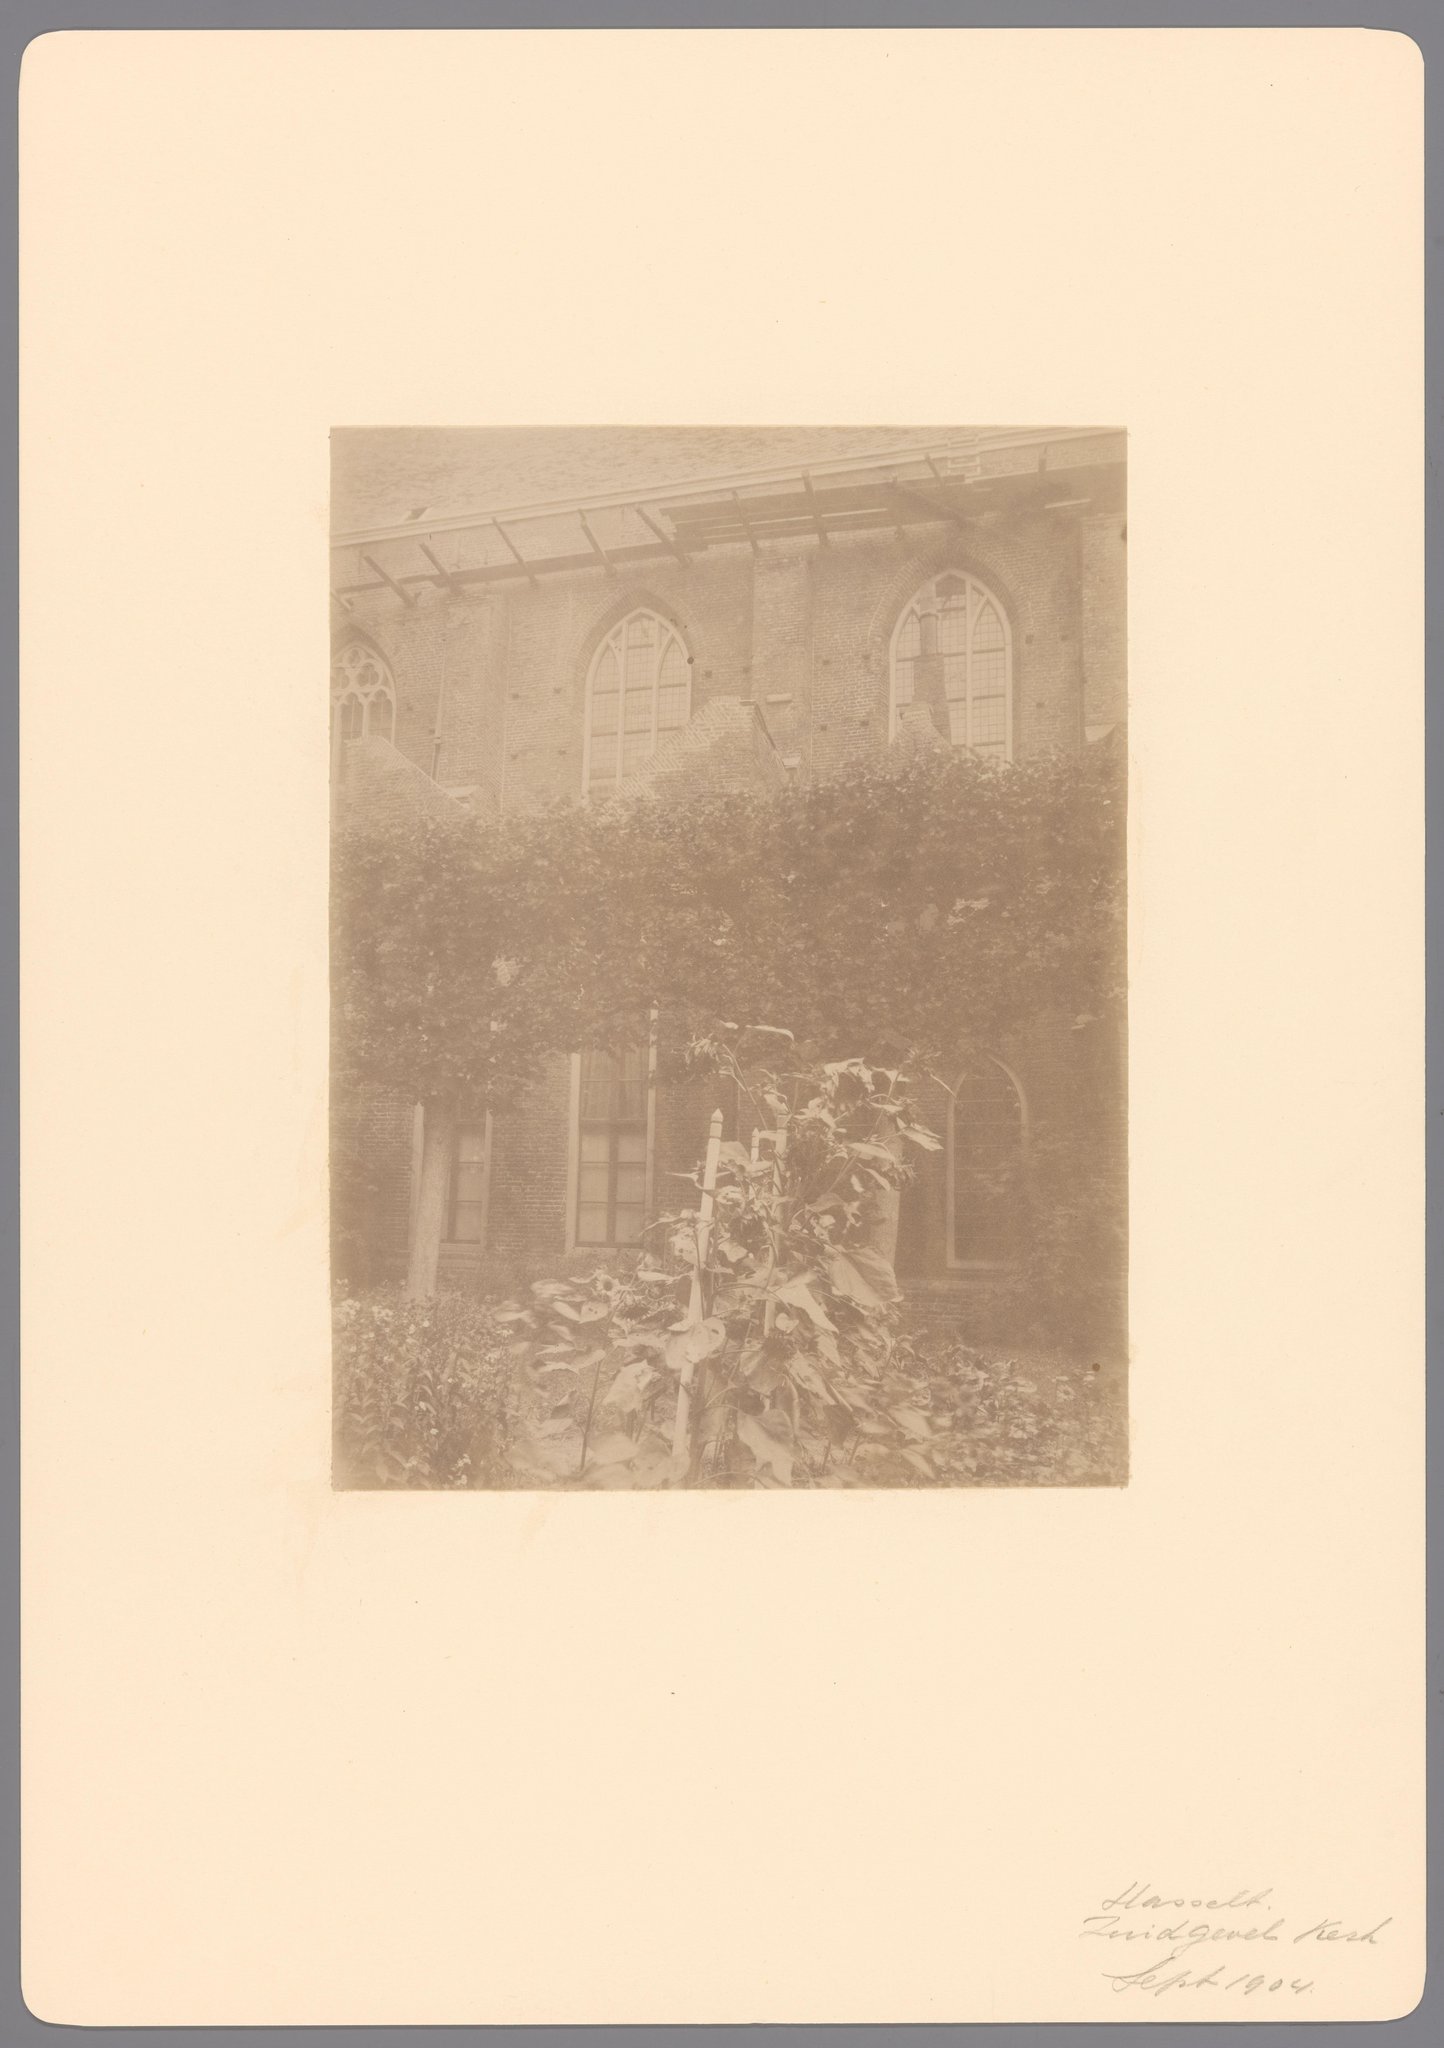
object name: photograph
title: Zuidzijde Grote of Sint-Stephanuskerk te Hasselt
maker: anoniem (monumentenzorg)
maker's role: fotograaf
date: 1904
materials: cardboard, photographic support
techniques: albumen print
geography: hasselt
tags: church (exterior)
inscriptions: annotation: ‘Hasselt/ zuidgevel kerk/ sept 1904’